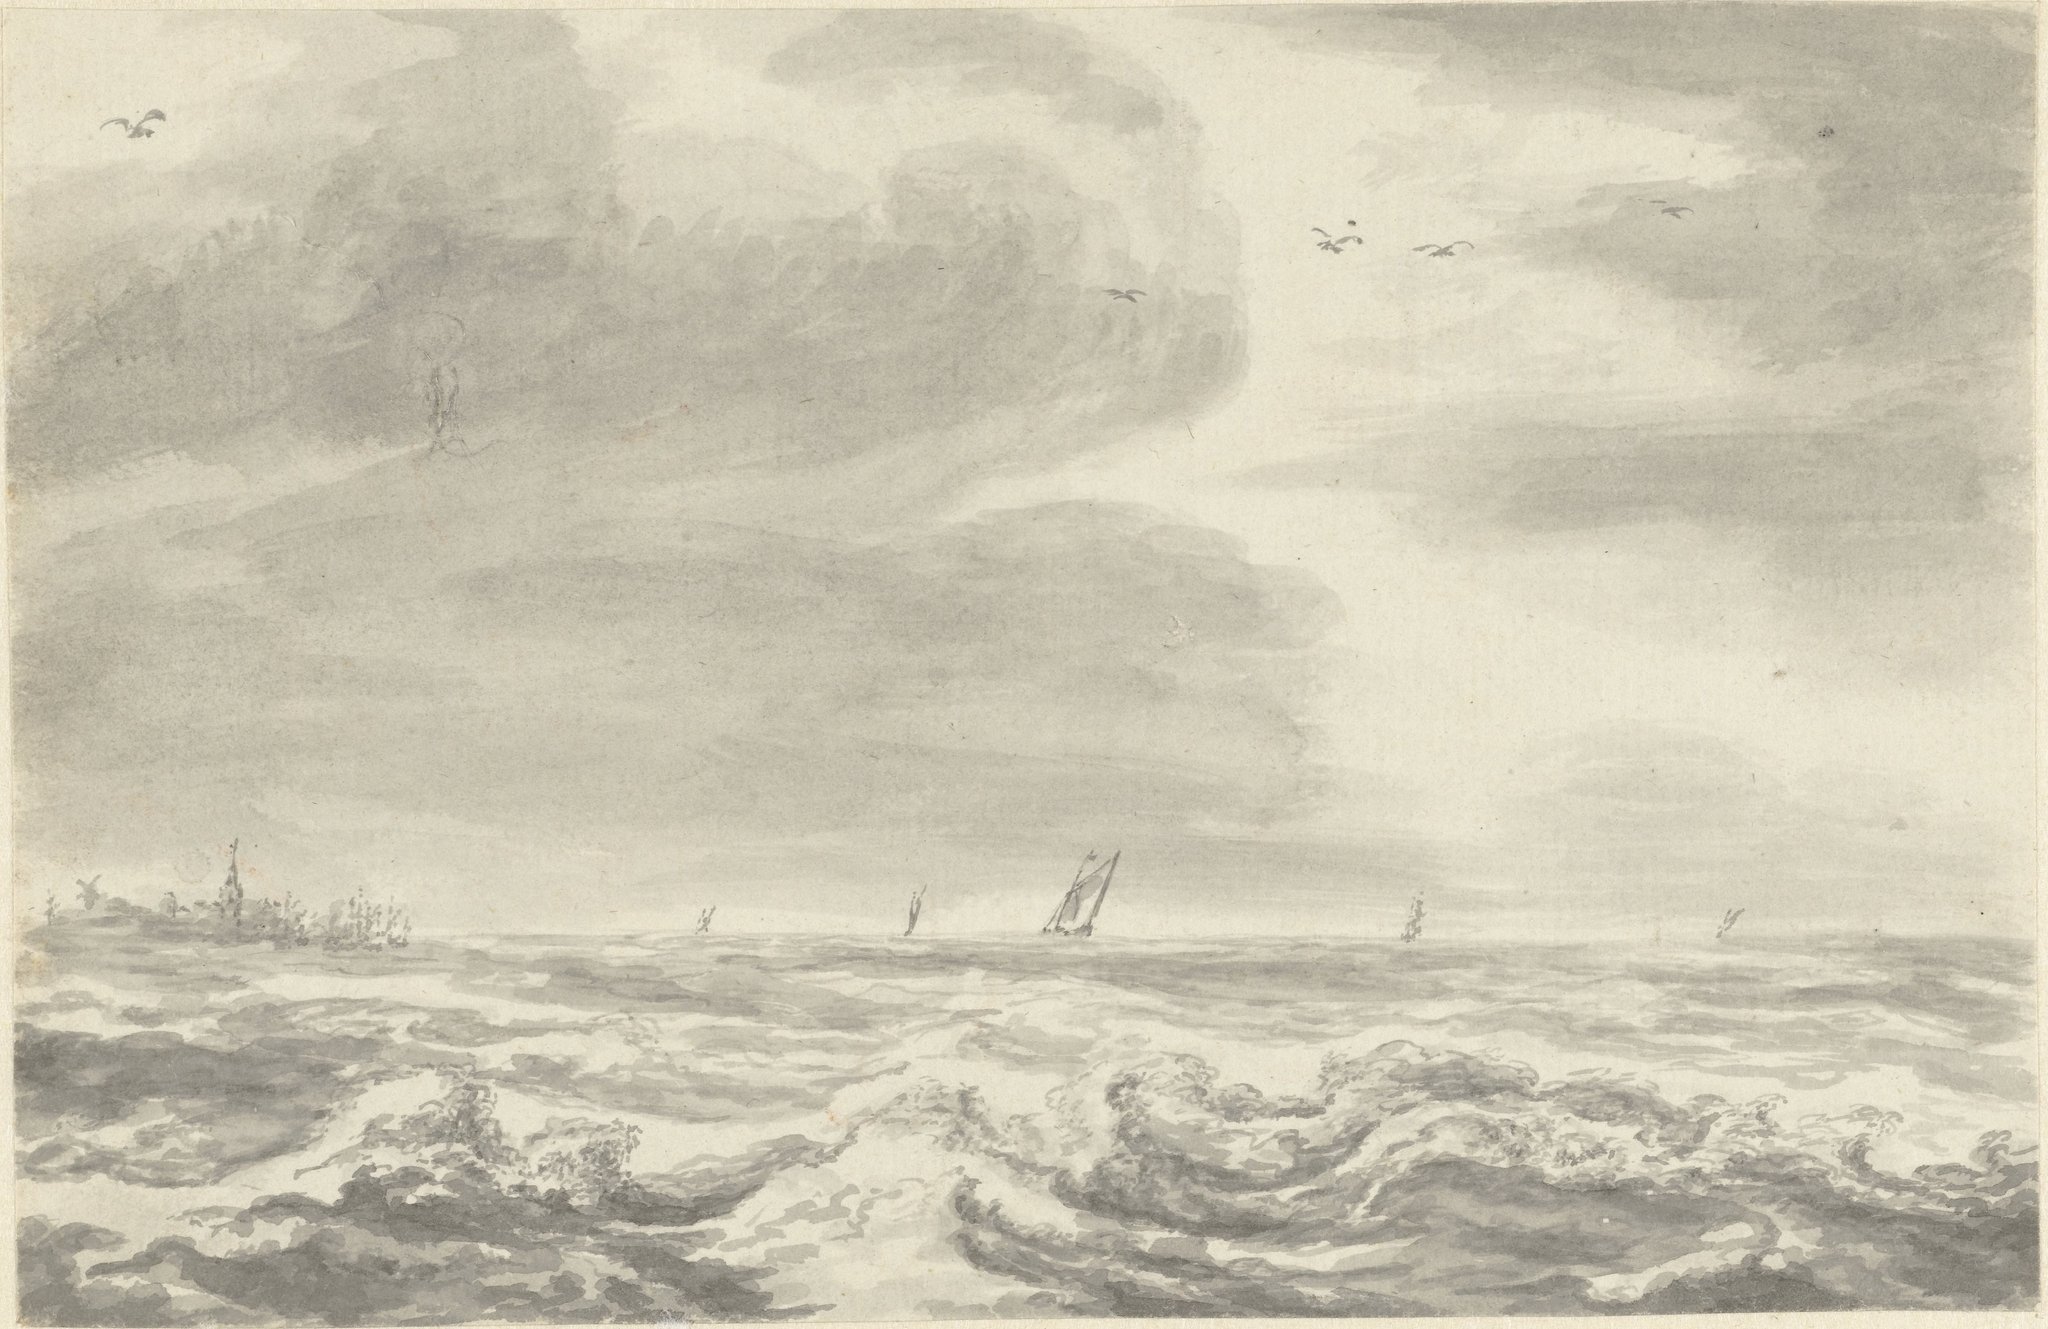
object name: drawing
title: Zeegezicht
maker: pieter idserts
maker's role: draughtsman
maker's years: 1698-1781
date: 1708-1781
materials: paper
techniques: brush